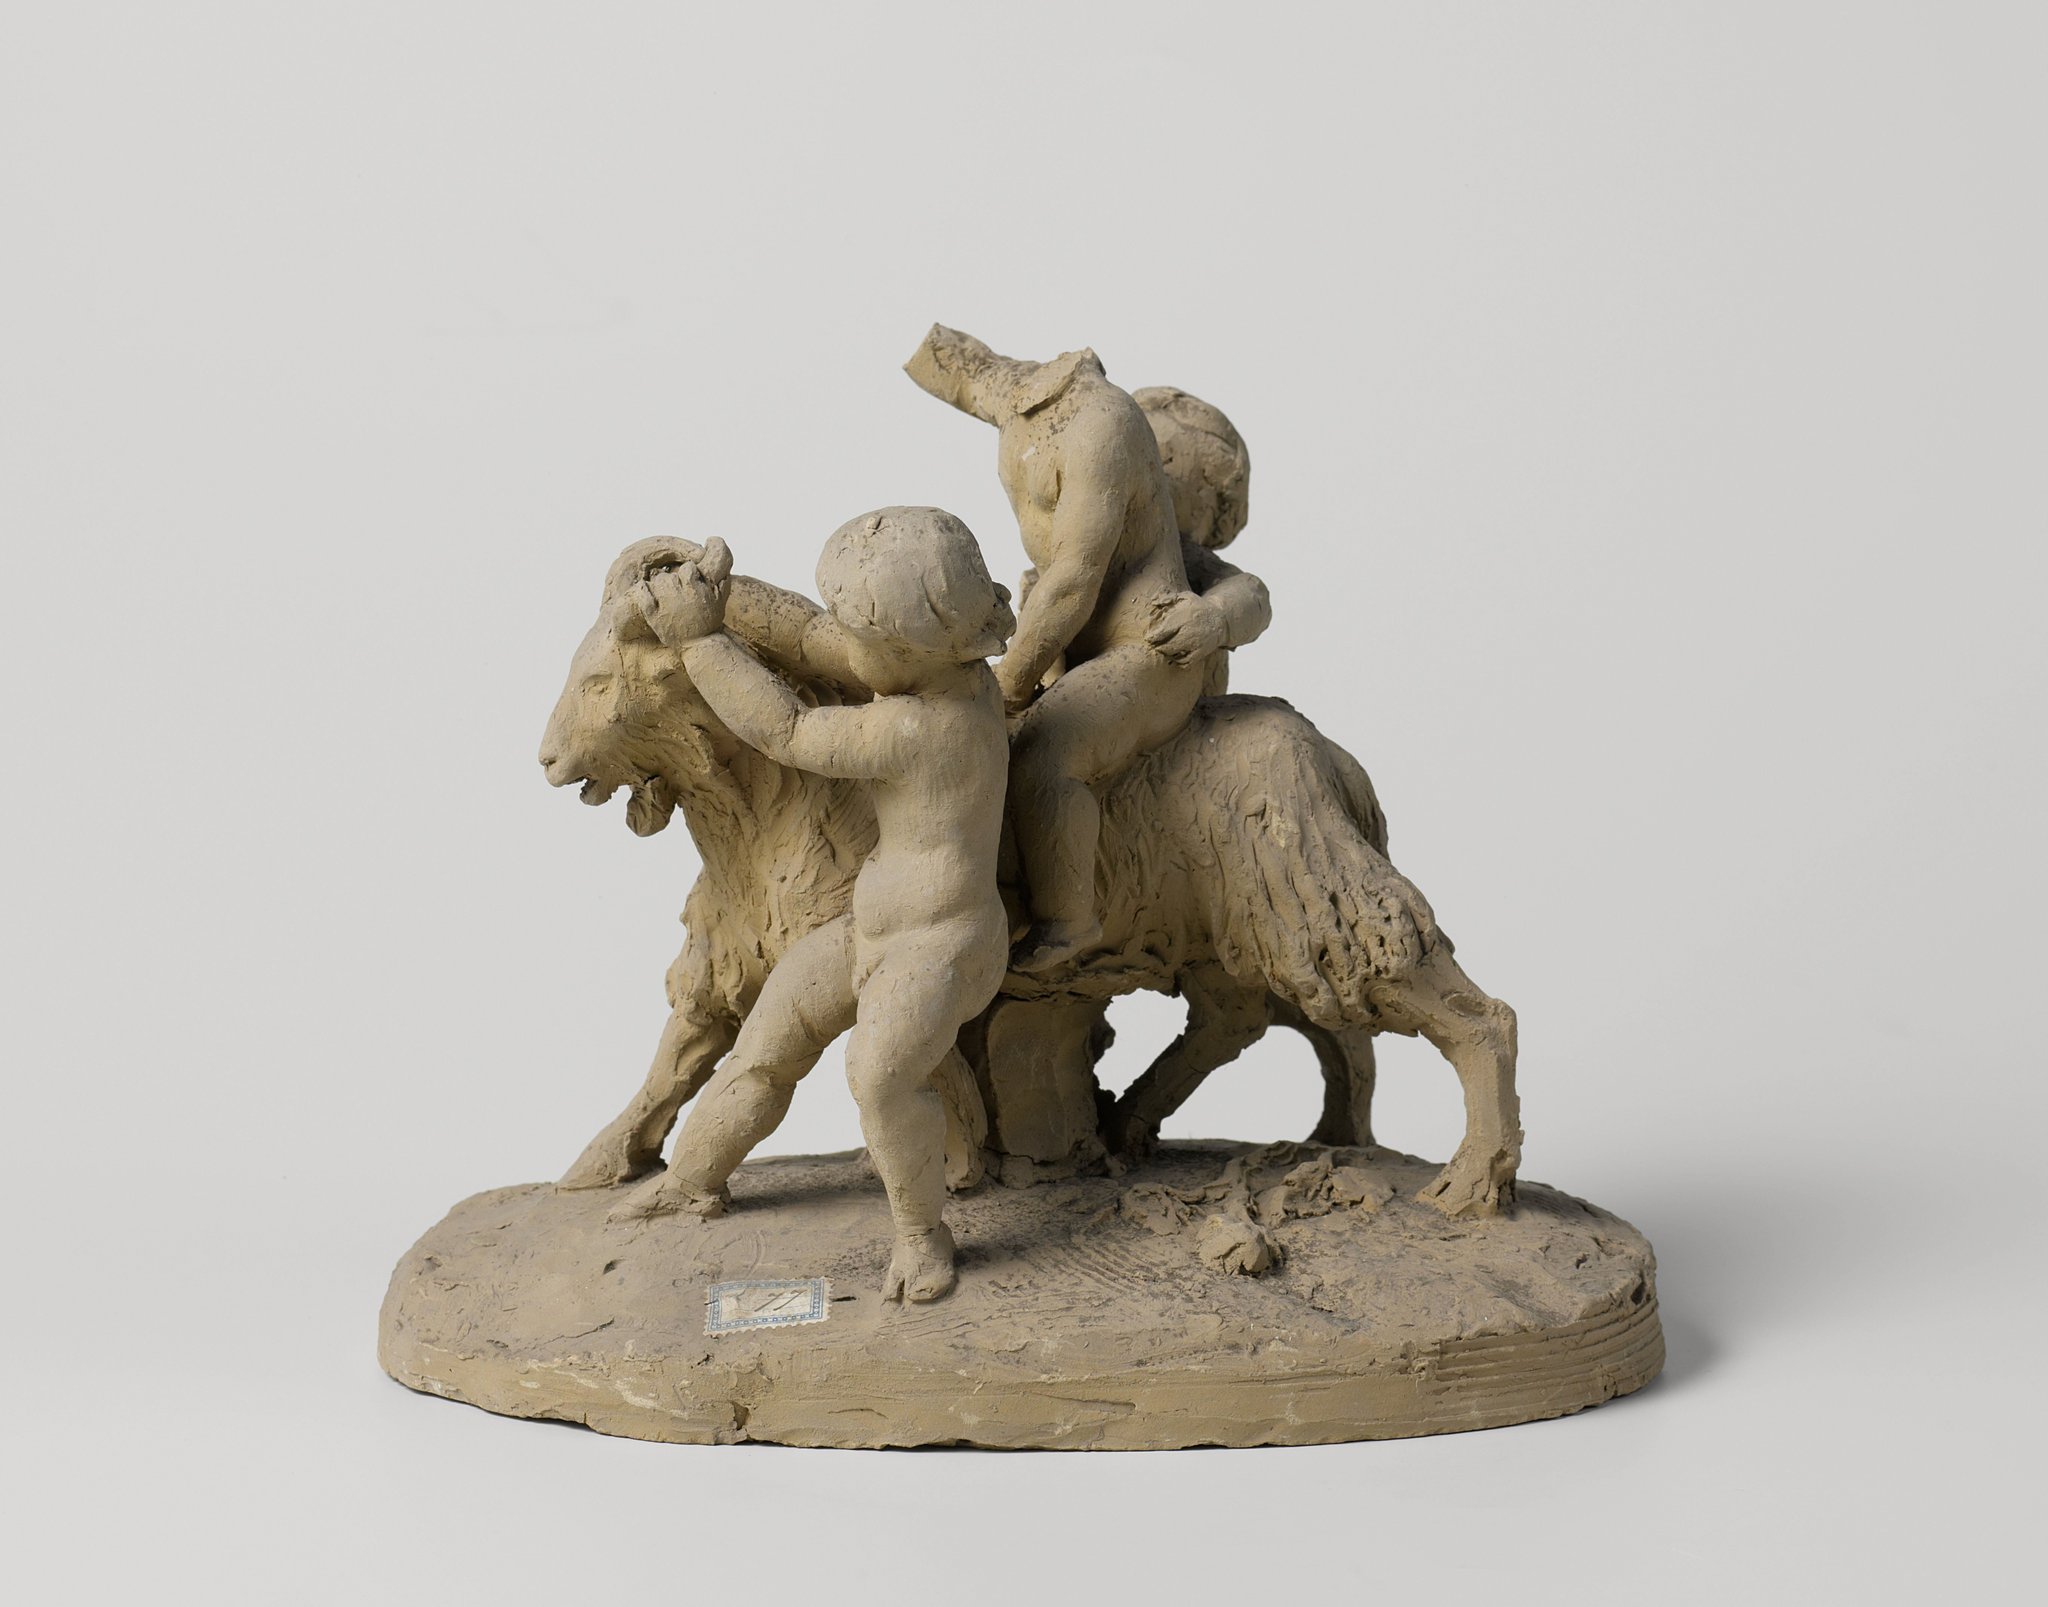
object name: sculpture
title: Drie kinderen spelend met een bok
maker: eugène lacomblé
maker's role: draughtsman, painter, sculptor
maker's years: 1828-1905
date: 1890-1900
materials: clay